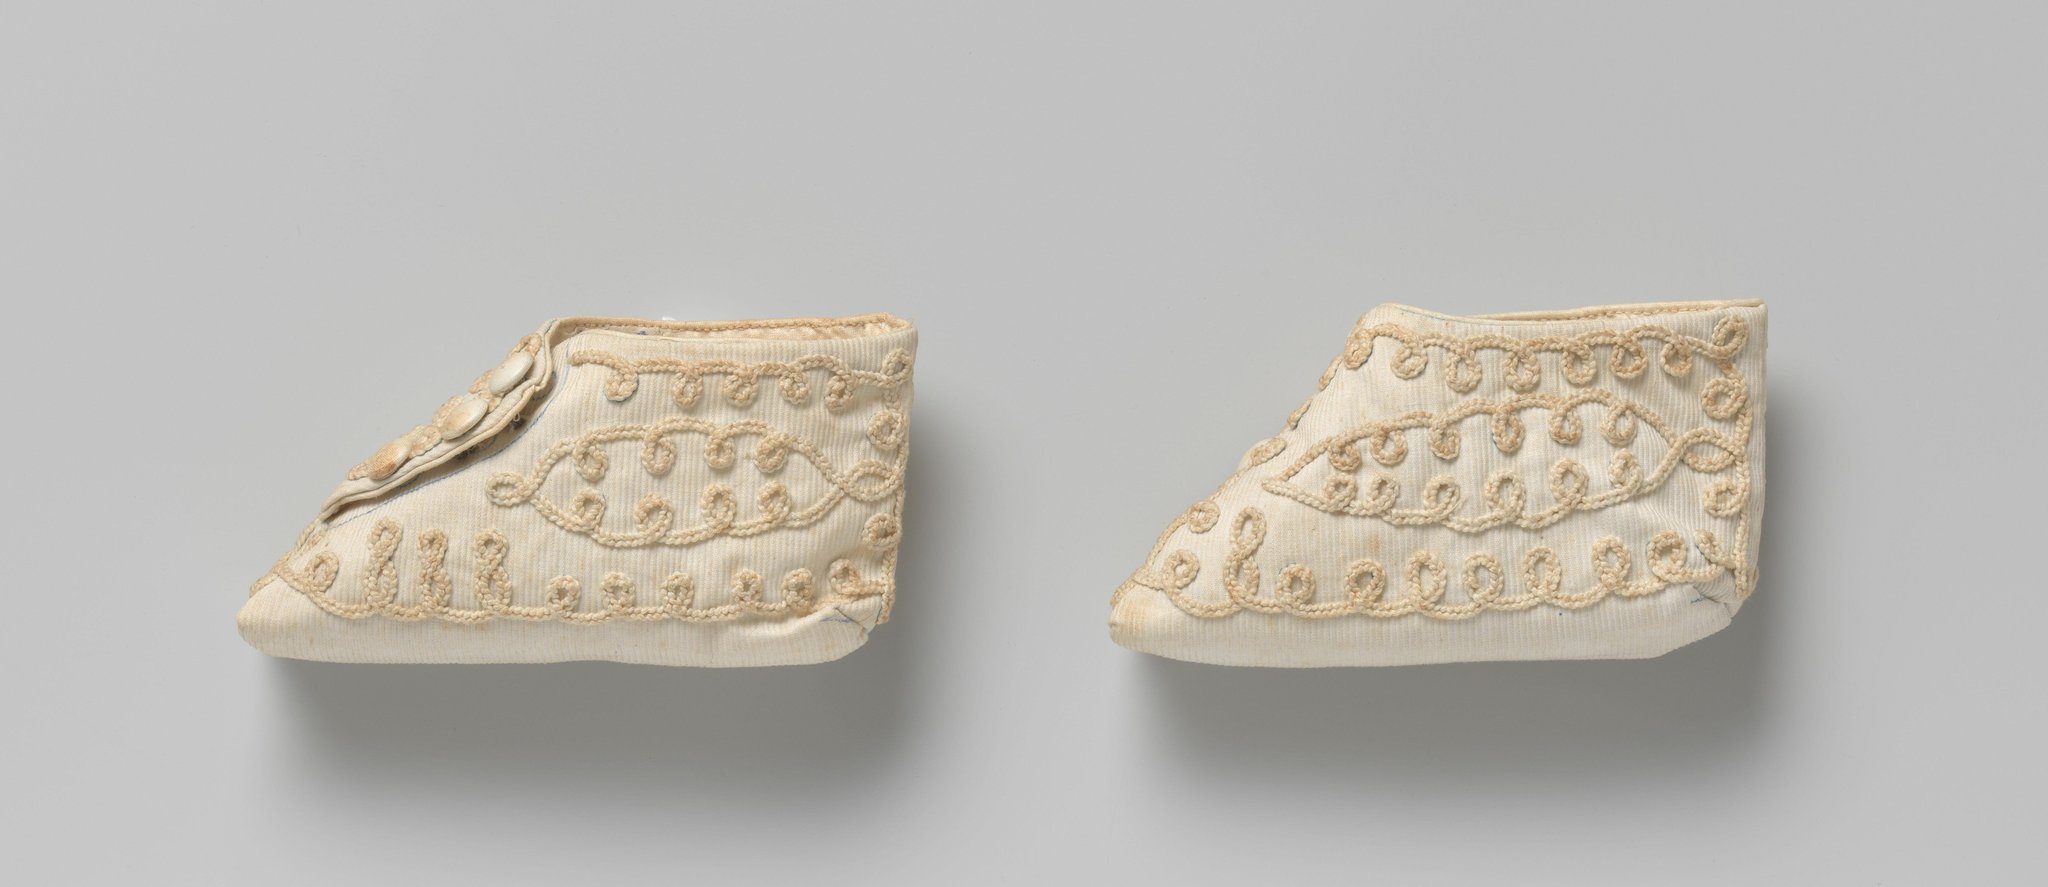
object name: childrenswear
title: Kinderschoen van wit piqué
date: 1800-1900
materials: textile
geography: paris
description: Een paar kinderschoenen van wit piqué met bandversiering. Sluiting door middel van twee haken en trensen. Langs de sluiting drie knopen met linnen overtrokken.